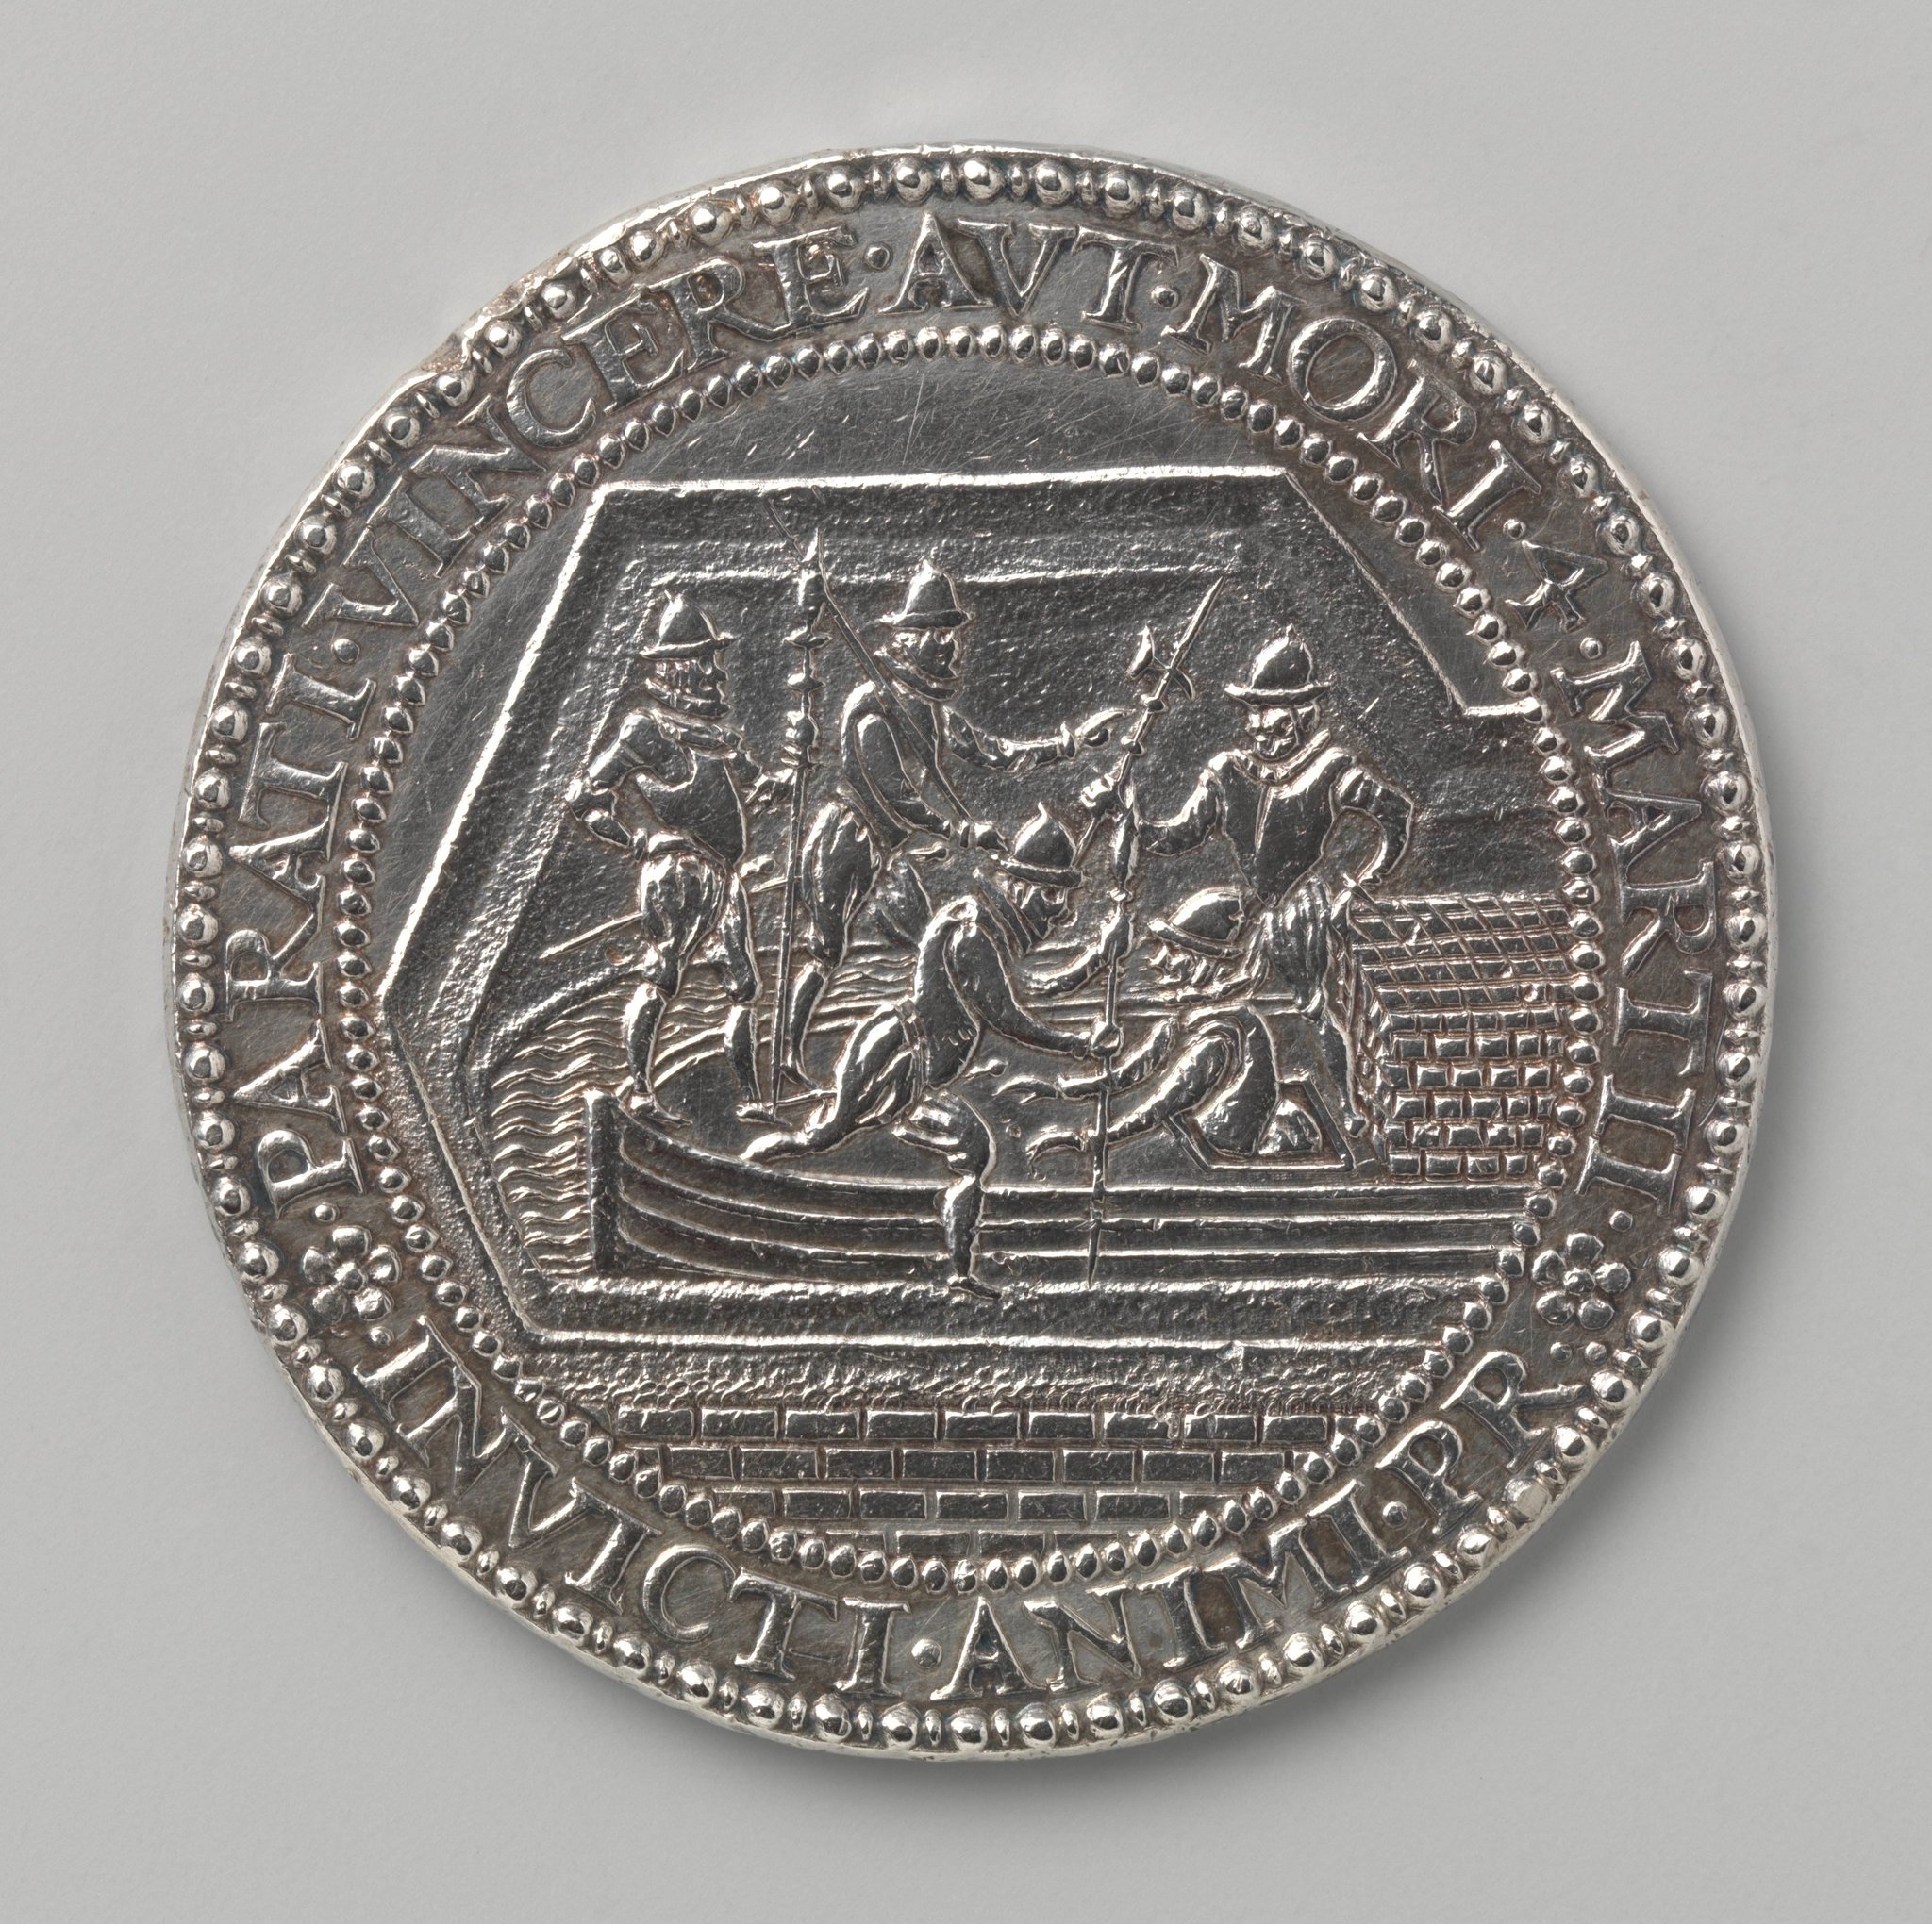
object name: triomfpenning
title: Capture of Breda with a Peat Barge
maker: gerard van bylaer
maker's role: die cutter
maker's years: 1540-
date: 1590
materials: silver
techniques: striking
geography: dordrecht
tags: the hague, maurice (prince of orange), coat of arms (as symbol of the state, etc.), surprise attack (stratagem)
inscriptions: circumscription: ‘INVICTI ANIMI PR PARATI VINCERE AVT MORI 4 MARTII’, circumscription: ‘BREDA A SERVITVTE HISPANA VINDICATA DVCTV PRINCIPIS MA VRITII A NASS Ao MDXC’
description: Zilveren penning. Voorzijde: uit een met turf geladen schip komen krijgers te voorschijn binnen omschrift. Keerzijde: opschrift onder gekroond wapenschild en leeuw met zwaard en pijlenbundel.